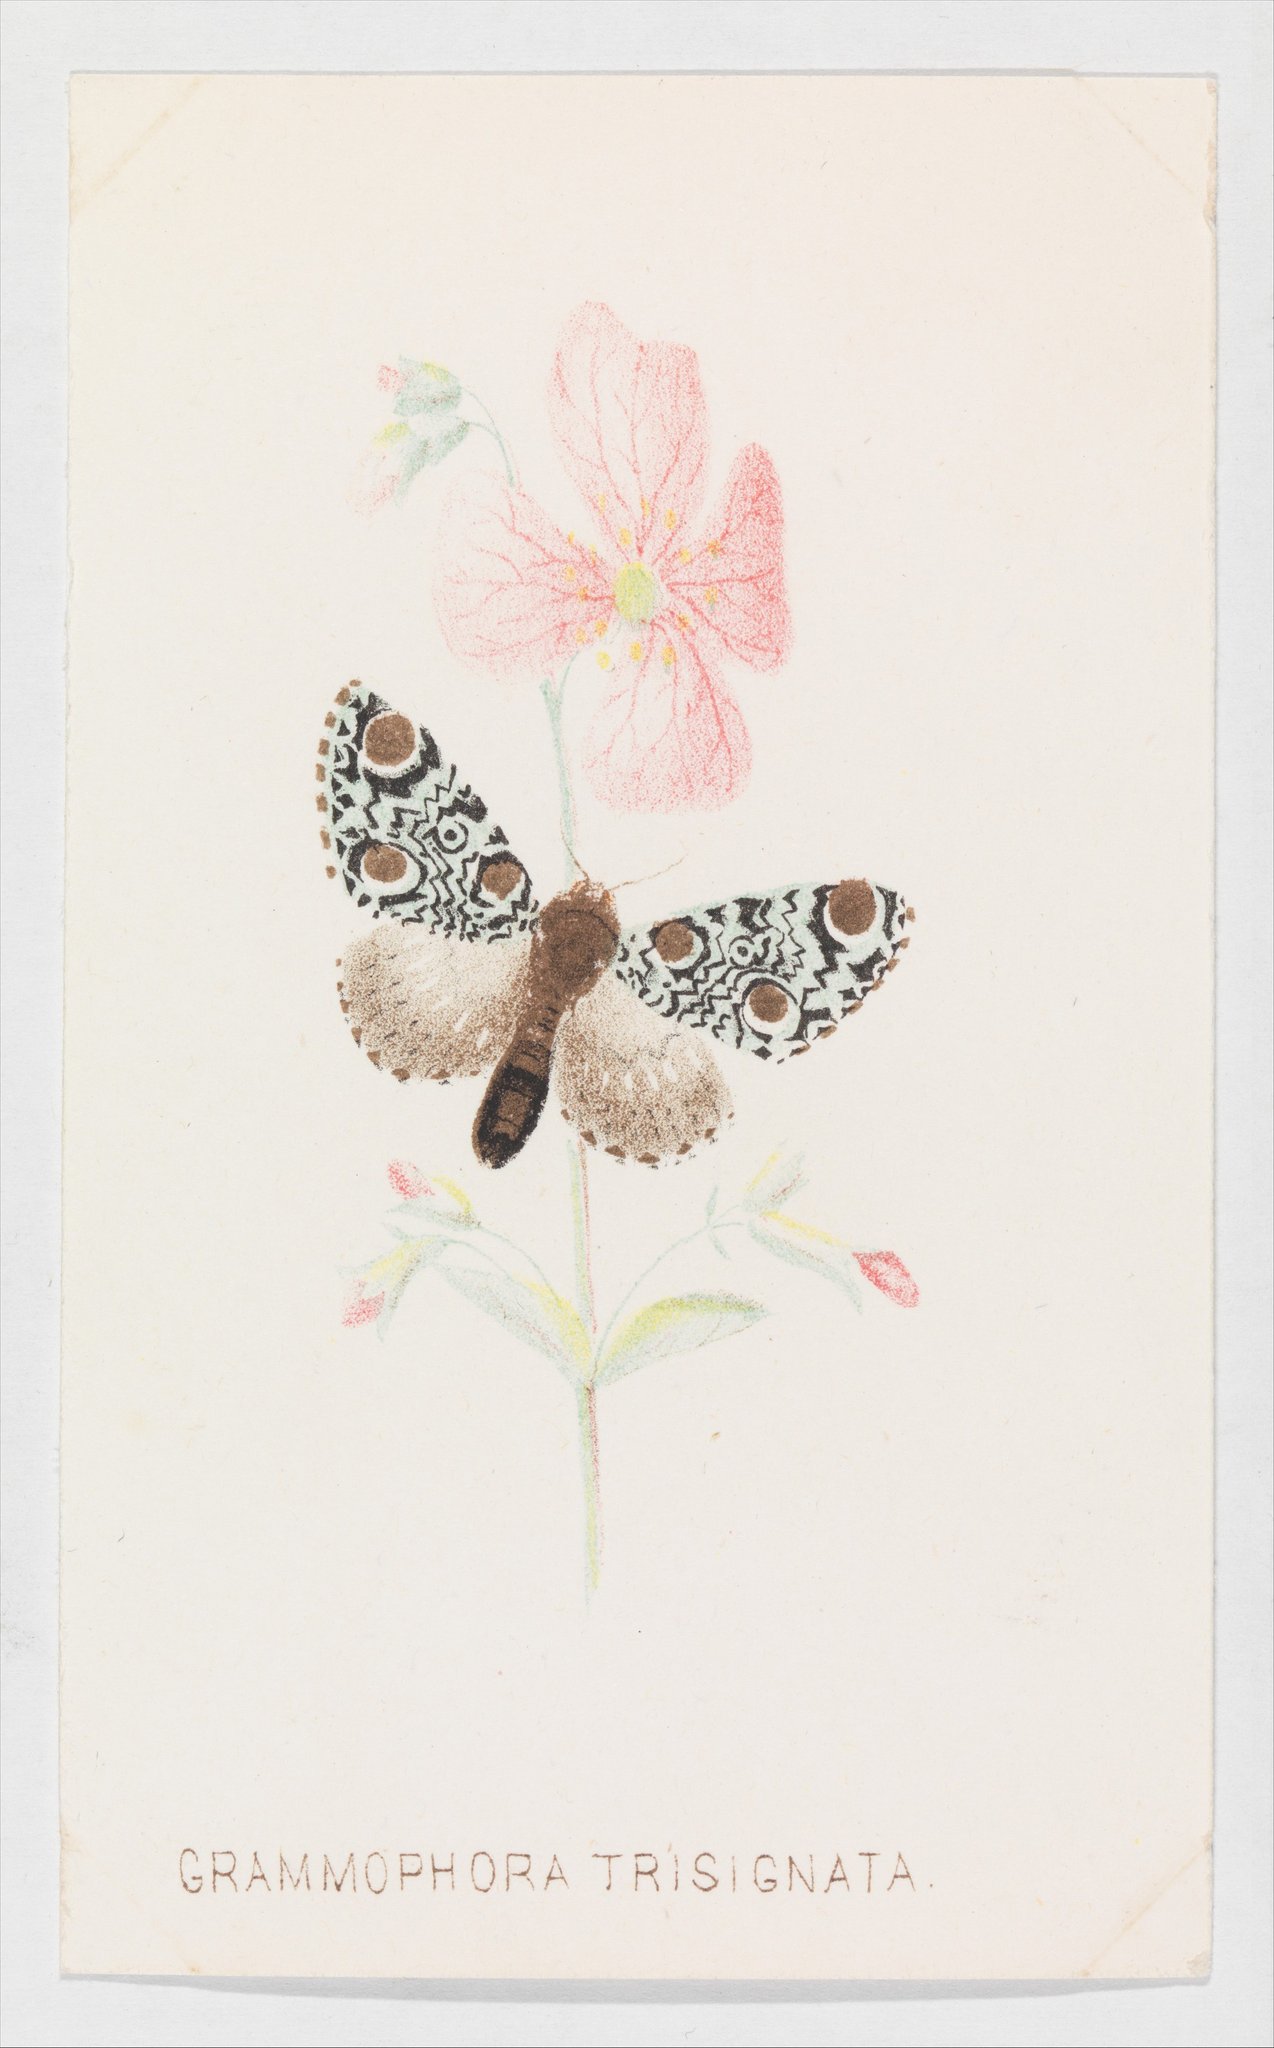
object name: print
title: Grammophora Trisignata, from "The Butterflies and Moths of America", Part 4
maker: louis prang & co.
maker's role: publisher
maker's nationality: american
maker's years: 1800-1950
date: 1862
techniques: lithograph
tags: butterflies